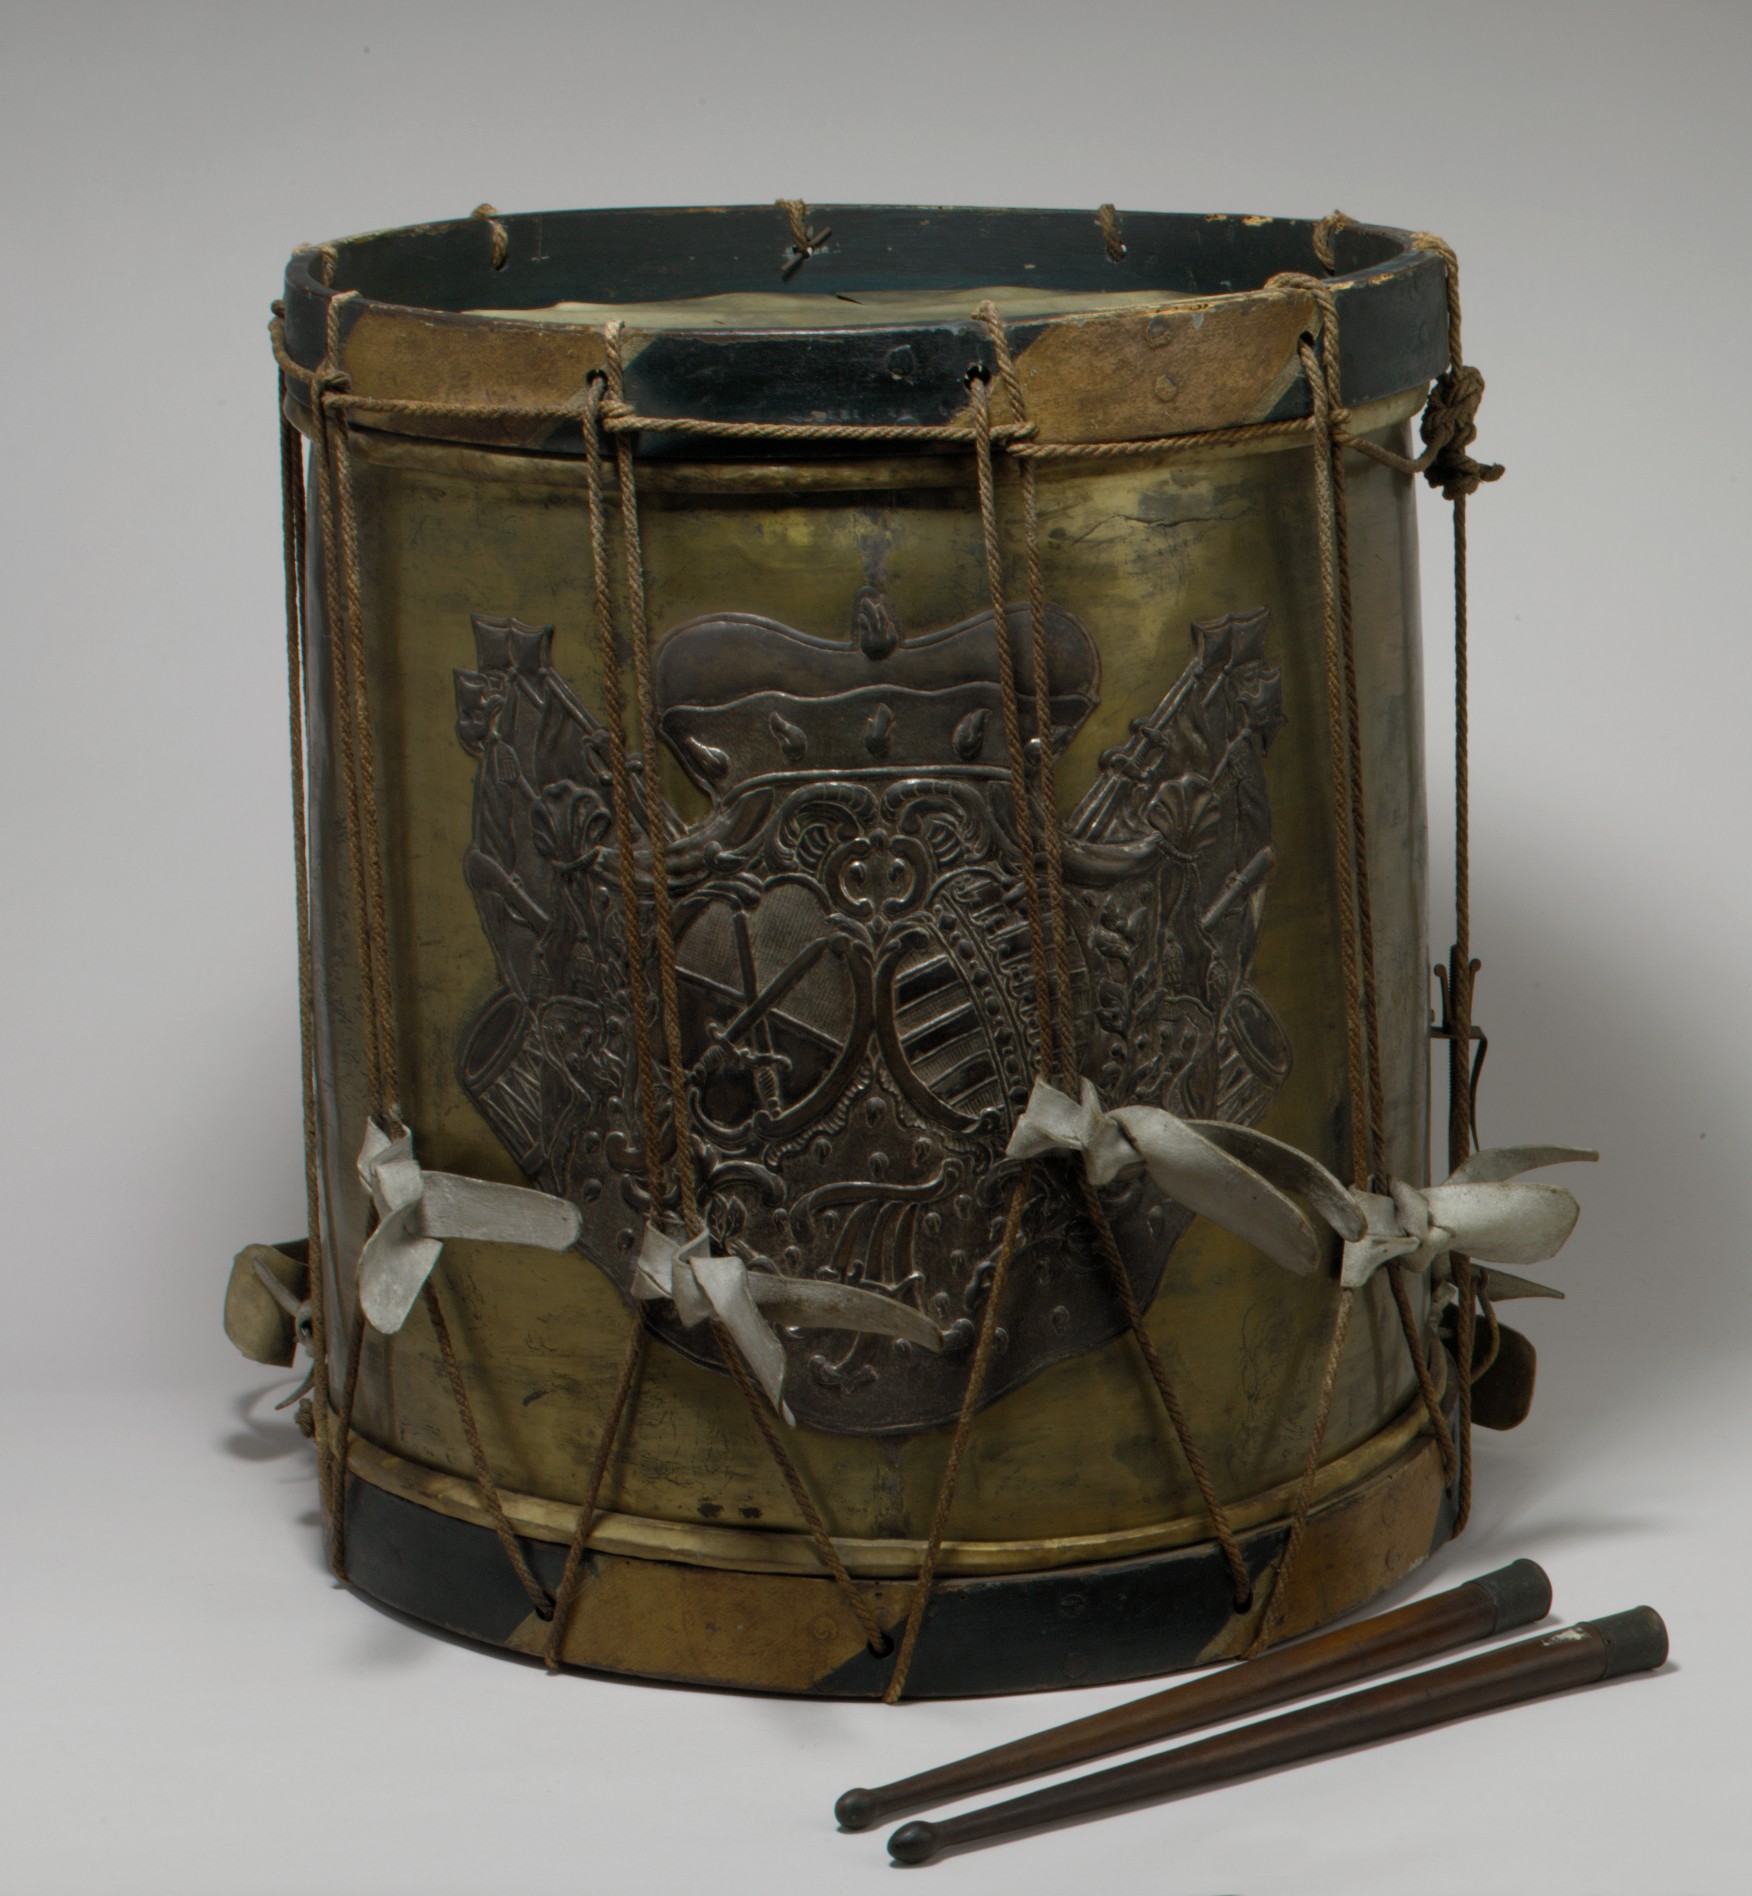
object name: side drum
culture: german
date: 1694-1733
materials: copper alloy, wood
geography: germany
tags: coat of arms